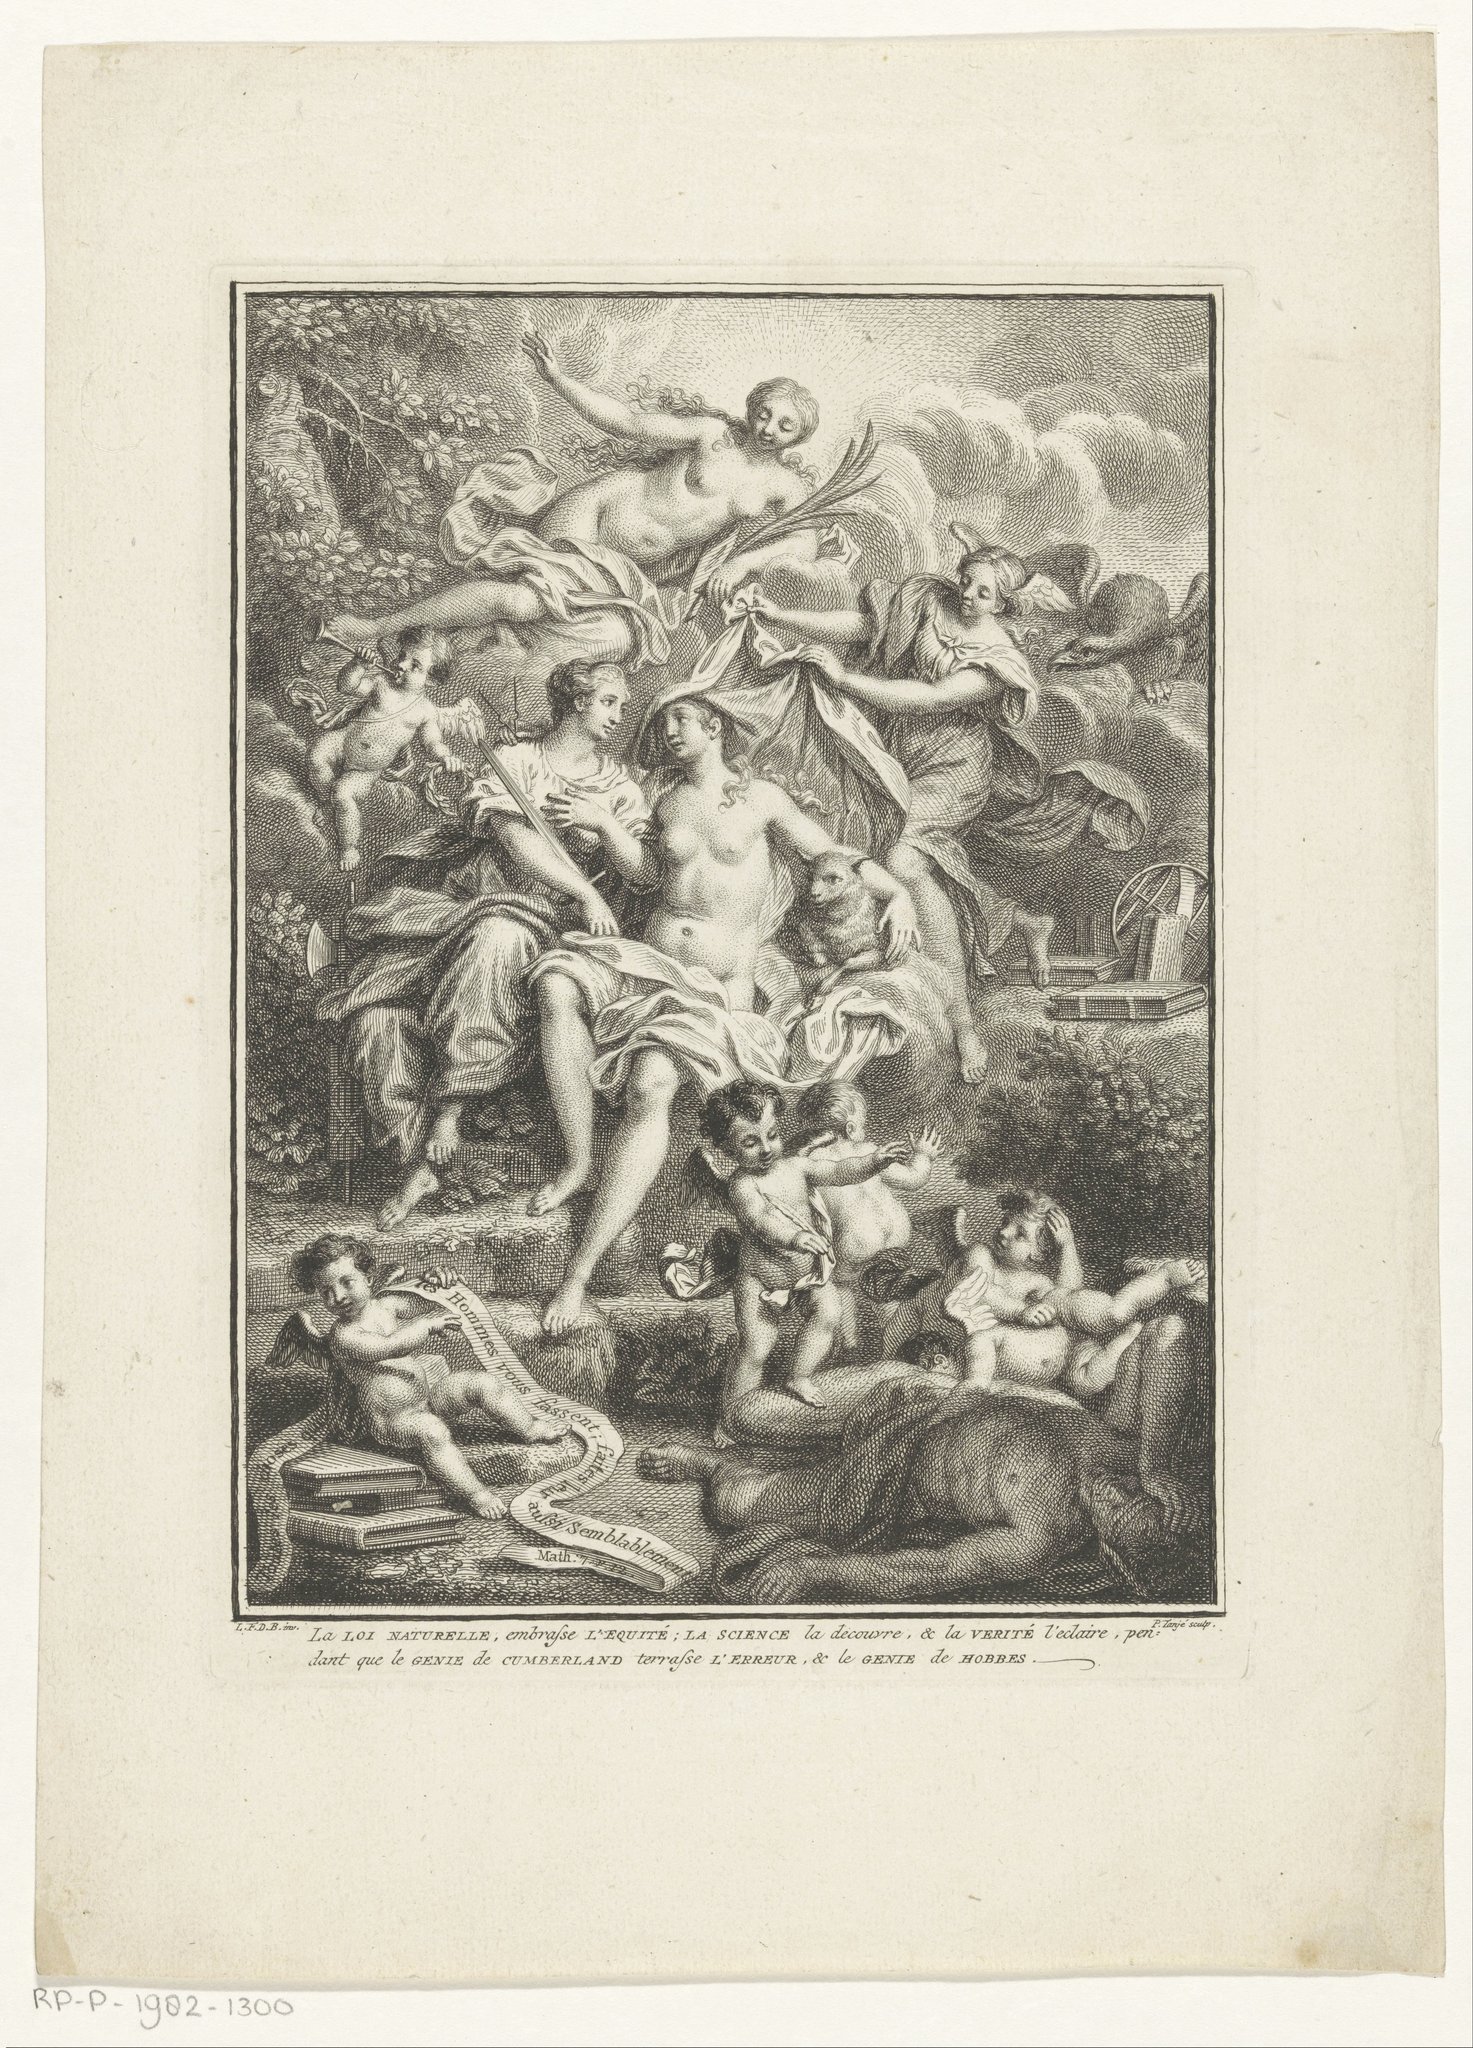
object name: print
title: Titelpagina voor: Richard Cumberland, Traité philosophique des loix naturelles, 1744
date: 1744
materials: paper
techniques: etching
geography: amsterdam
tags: 'natura' (allegorical figure or scene; or as diana of ephesus, with many breasts); 'natura' (ripa), symbolic representations, allegories and emblems ~ science, 'scientia'; 'scienza', 'studio' (ripa), truth; 'verità' (ripa), error; 'errore' (ripa), equality, equity, fairness, righteousness; 'equalità', 'equità', 'giuditio giusto', 'ordine dritto e giusto', 'ugualità' (ripa)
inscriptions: collector's mark: Lugt 2228, collector's mark: Lugt 2760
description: Titelpagina voor een boek van Richard Cumberland, waarin hij de ideeën van Thomas Hobbes bestrijdt. De Wet van de Natuur, in de persoon van Venus, omarmt het Gelijk. Zij houdt een zwaard in de hand. De Wet van de natuur wordt door Wetenschap ontsluierd en door Waarheid verlicht. Putti, die het genie van de schrijver Richard Cumberland personifiëren, overwinnen de Fout van Thomas Hobbes, die op de grond ligt. In de ondermarge een tweeregelige Franse tekst.